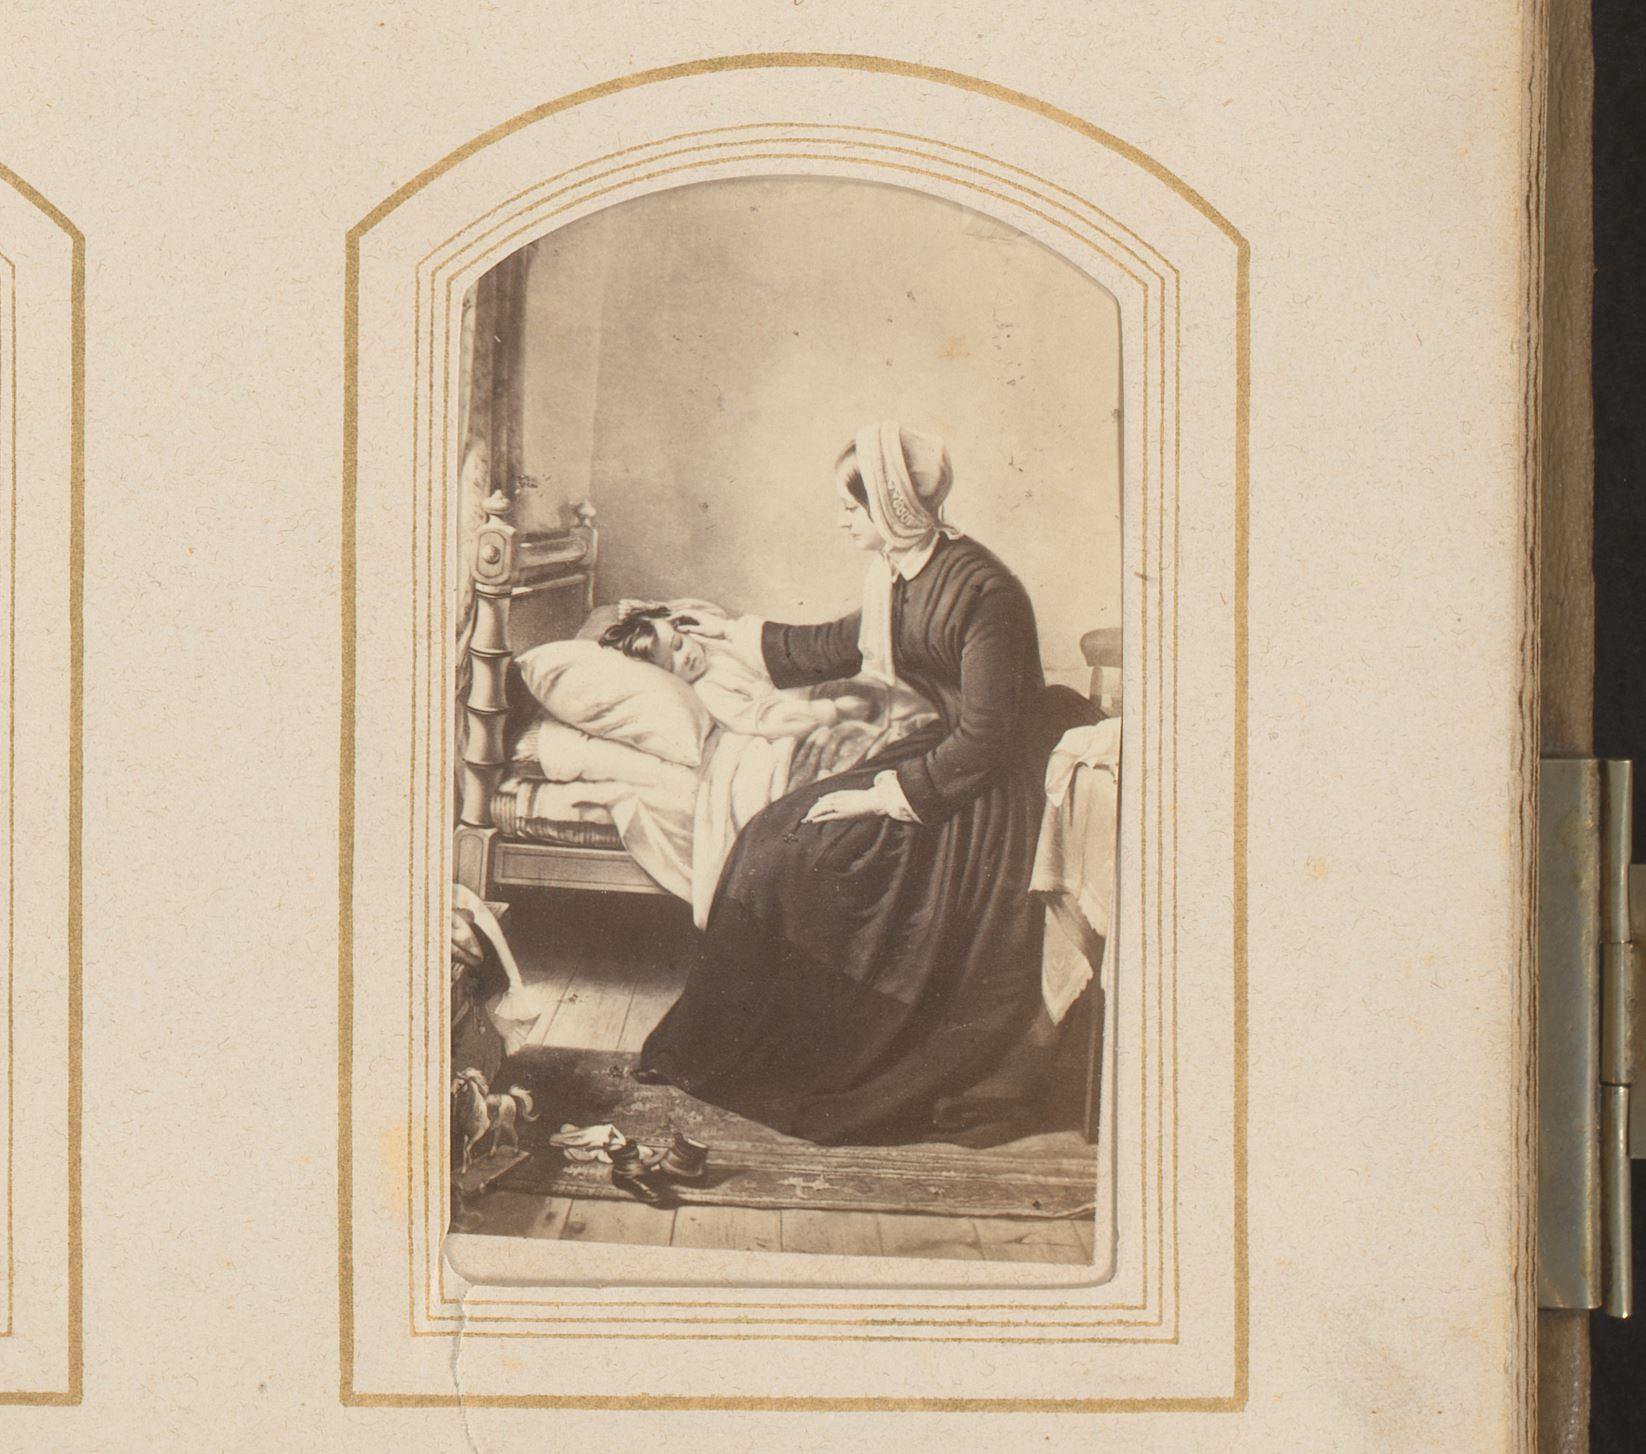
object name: reproduction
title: Fotoreproductie van La benediction maternelle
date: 1870-1890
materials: cardboard, photographic support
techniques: albumen print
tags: watching a sleeping child, painting, drawing and the graphic arts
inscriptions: annotation: ‘Müttersjungen’, number: ‘141’